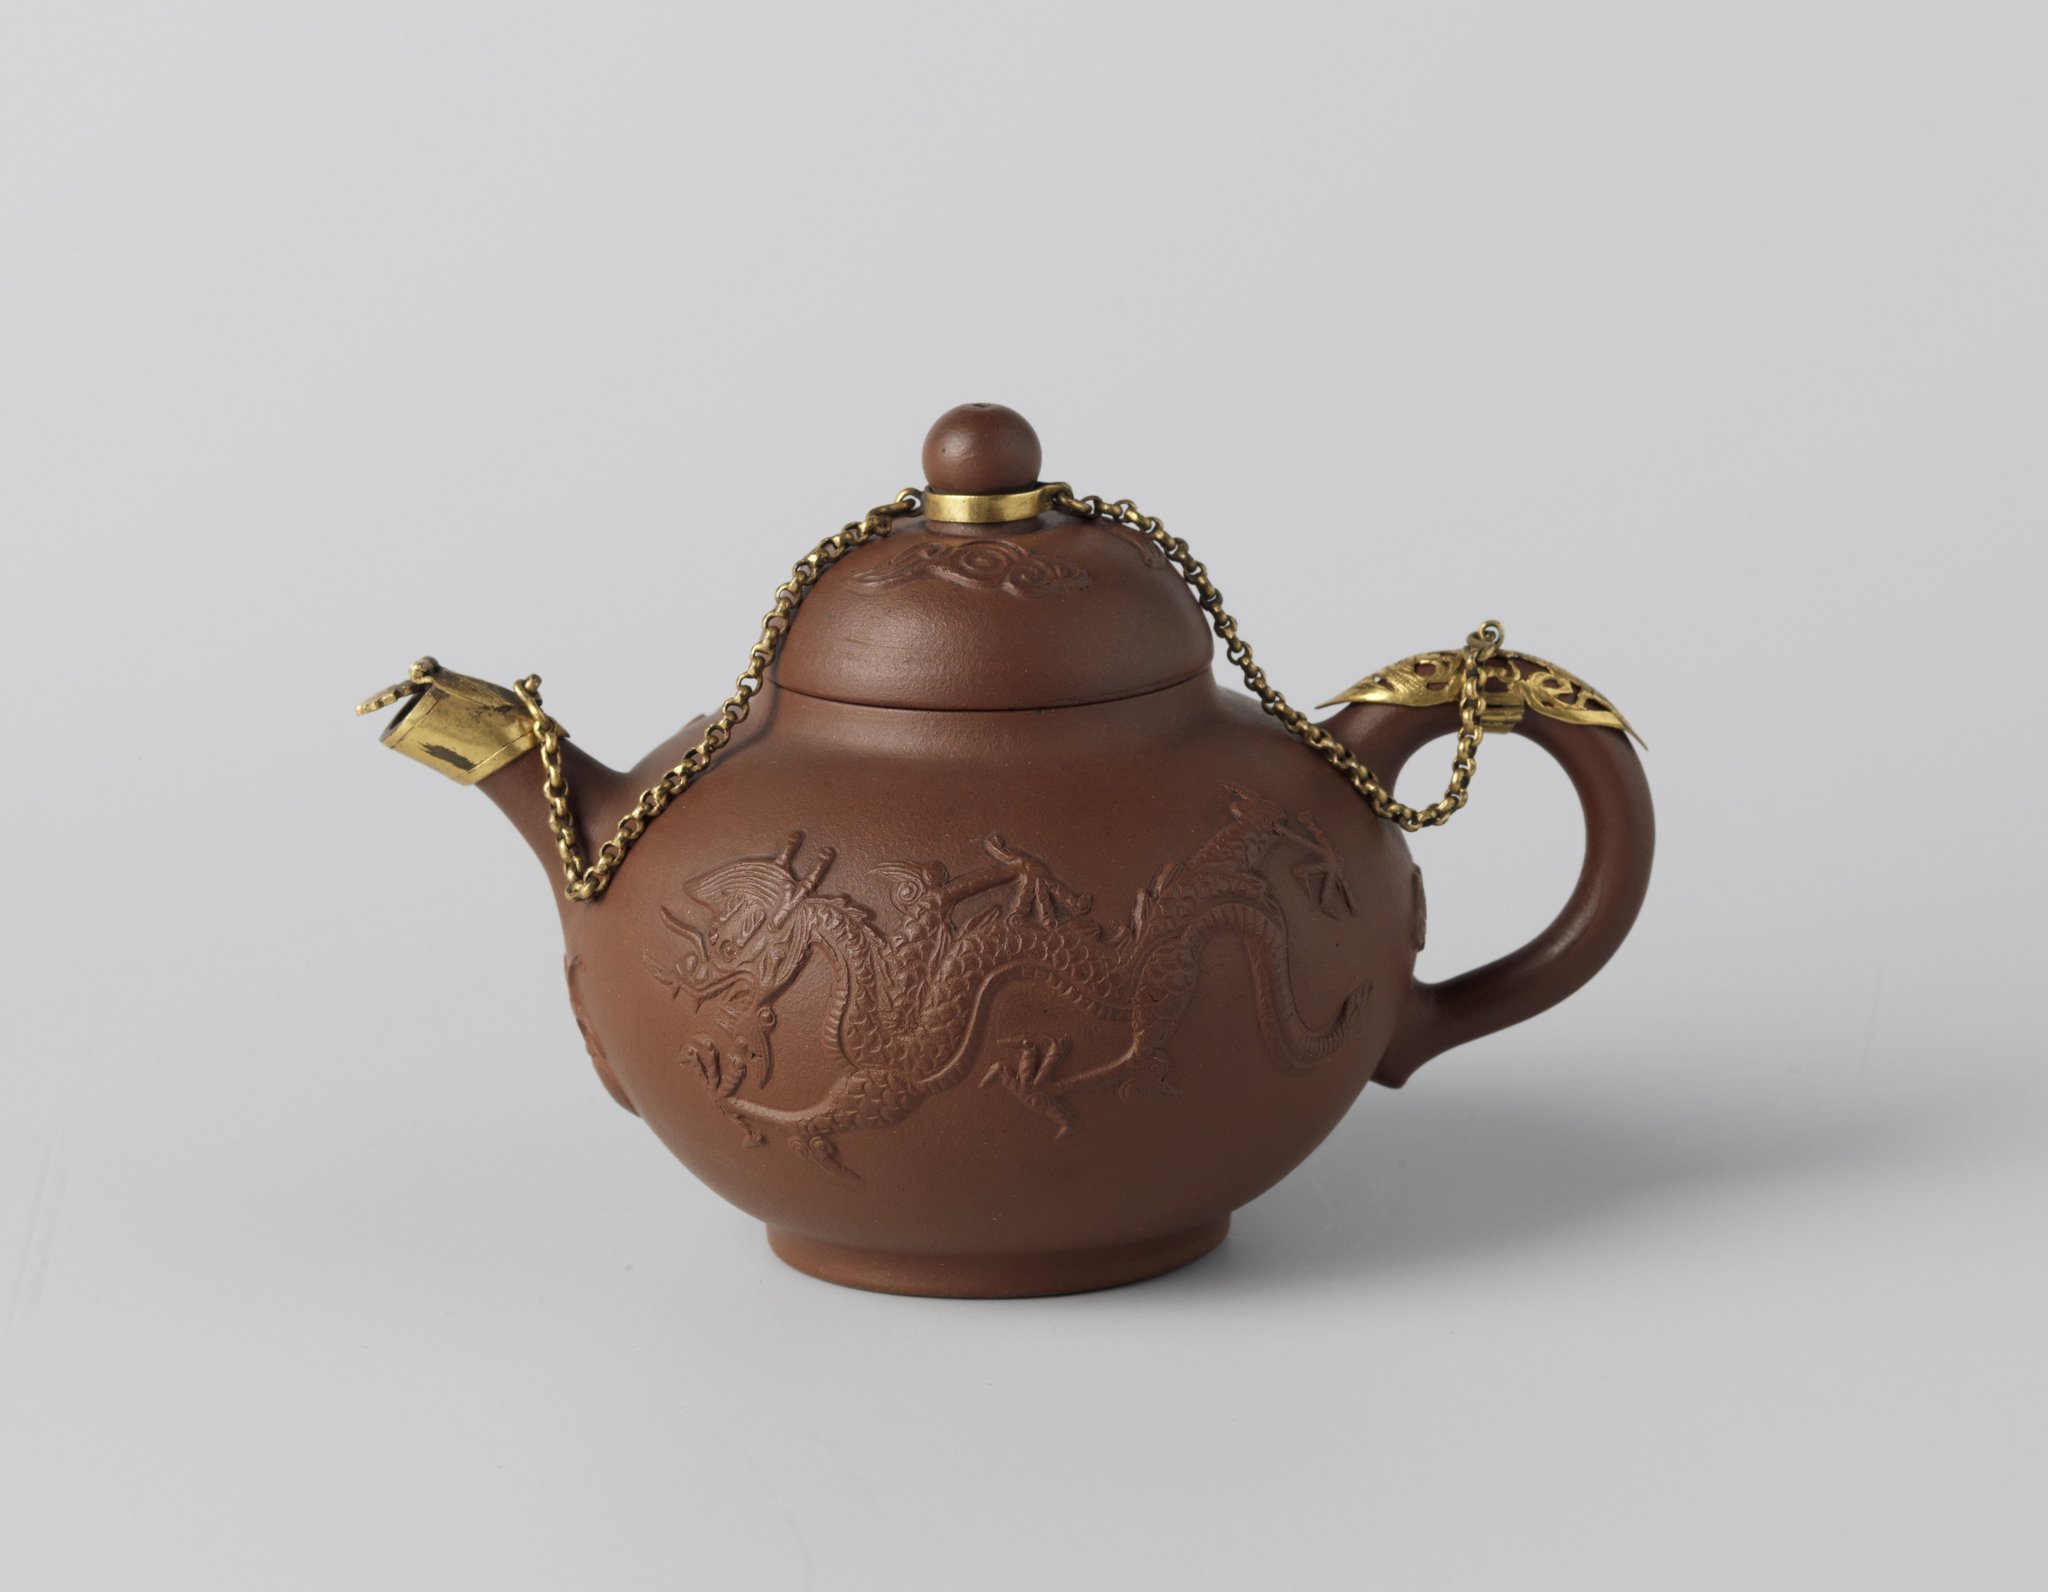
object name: teapot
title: Thepot with two pearl chasing dragons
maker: Anonymous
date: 1700-1799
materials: bronze, glaze, gold, porcelain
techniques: firing, gilding, relief, turning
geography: china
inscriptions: mark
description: Two dragons chasing a flaming pearl is a traditional auspicious motif in Chinese culture. In contrast to its European counterpart, where dragons are often associated with malevolence, in China they symbolize positive attributes, such as strength and invincibility. Once the teapot was in Europe, it was fitted with the gilt-bronze chain and decorations on the handle and spout to protect its more delicate parts.